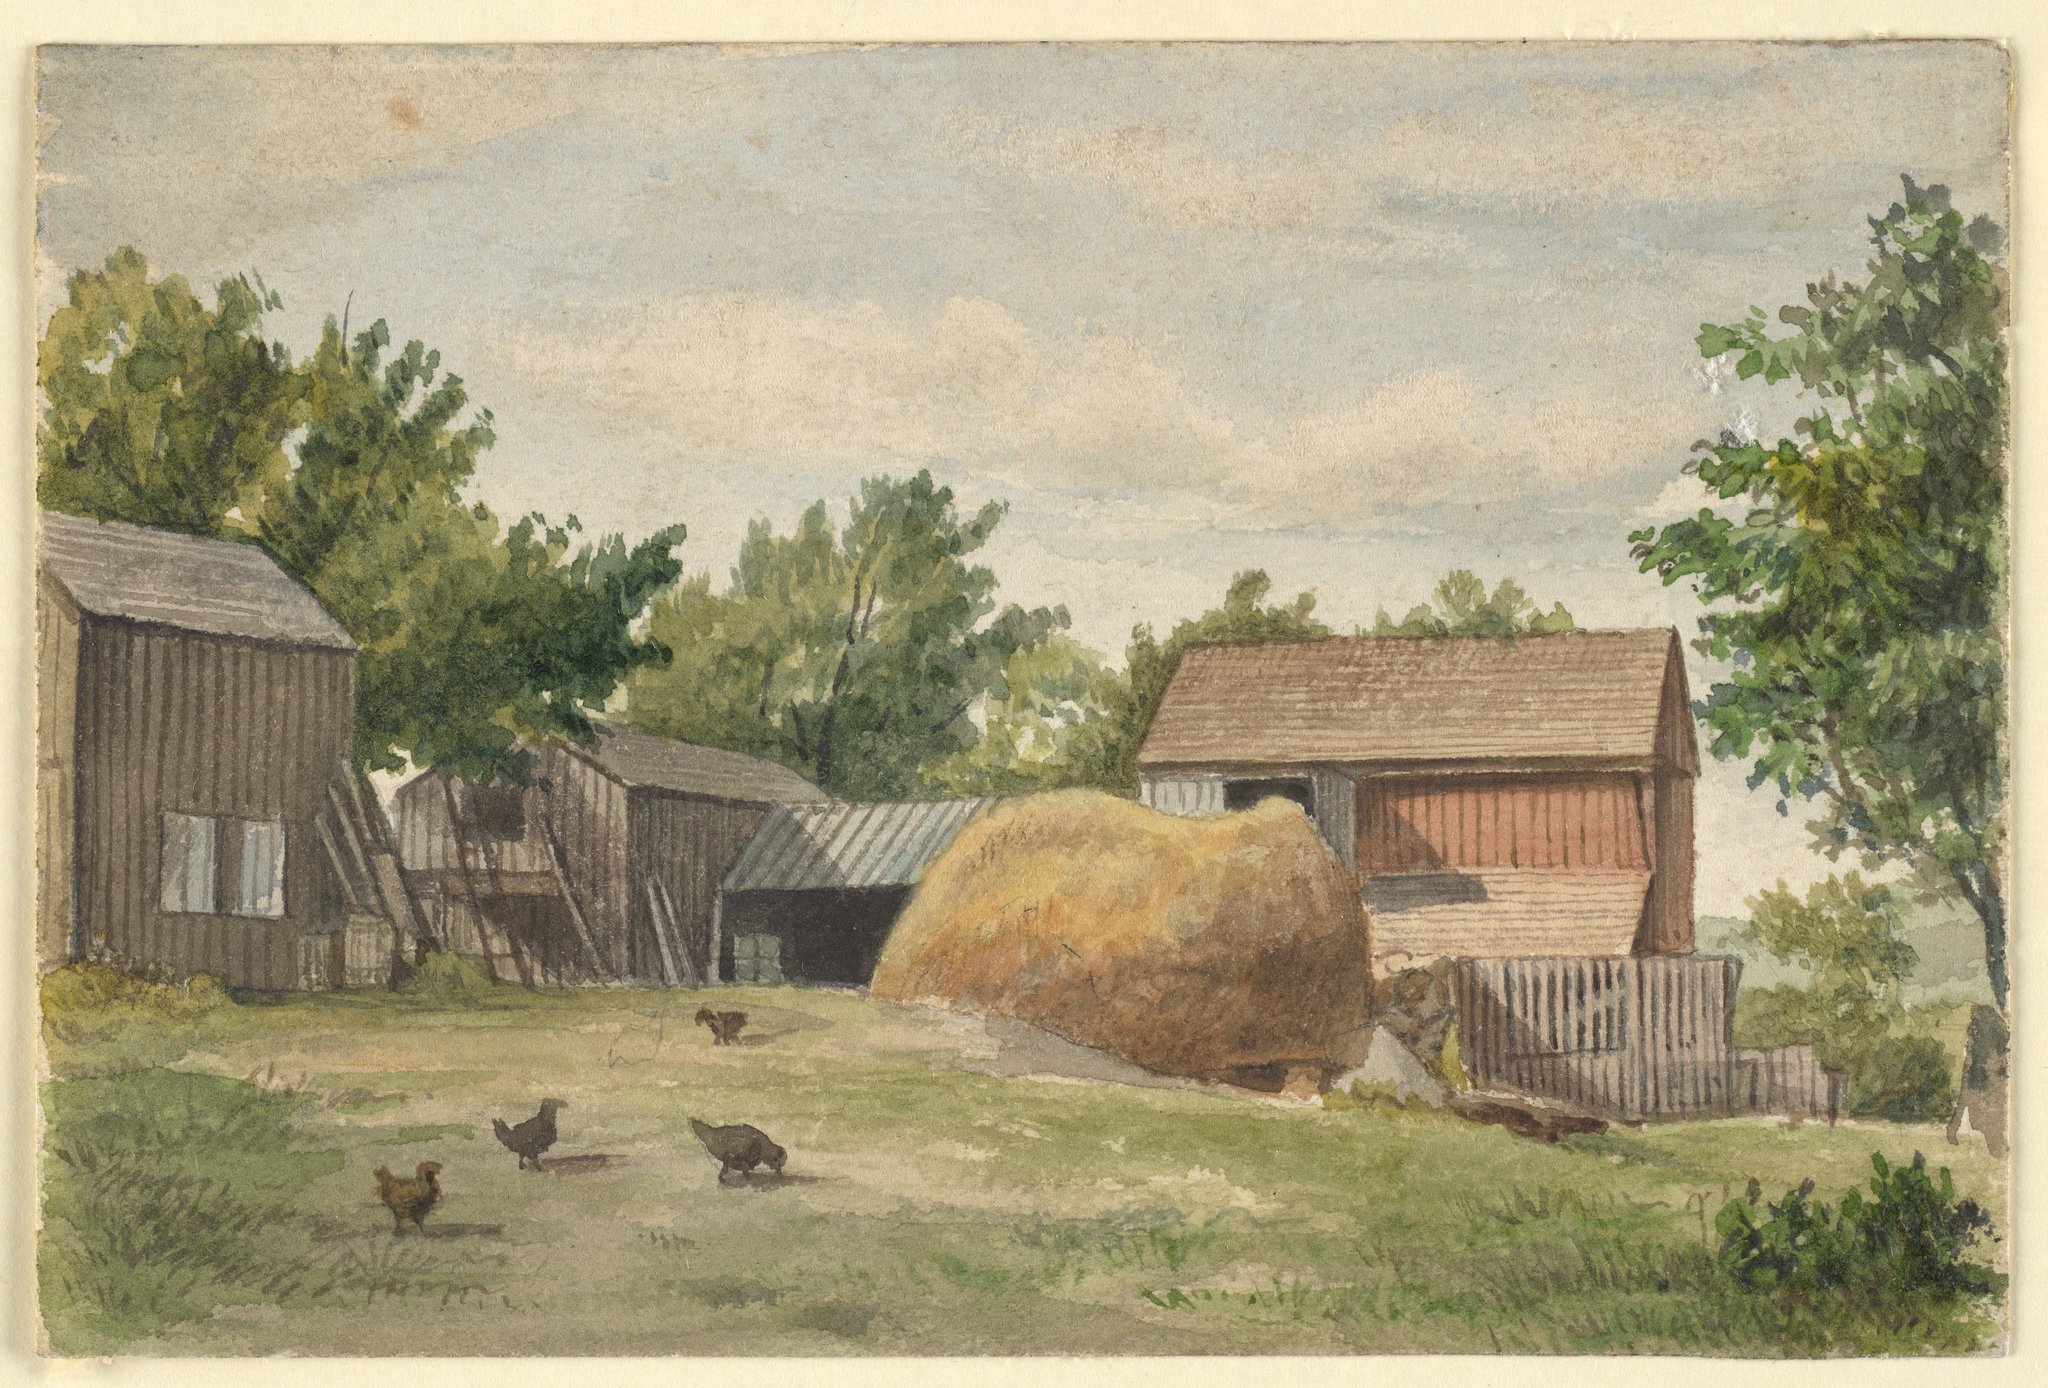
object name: drawing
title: Farm Scene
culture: american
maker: american artist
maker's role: artist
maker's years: 1851-1899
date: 1851-1900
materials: watercolor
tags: chickens,farms